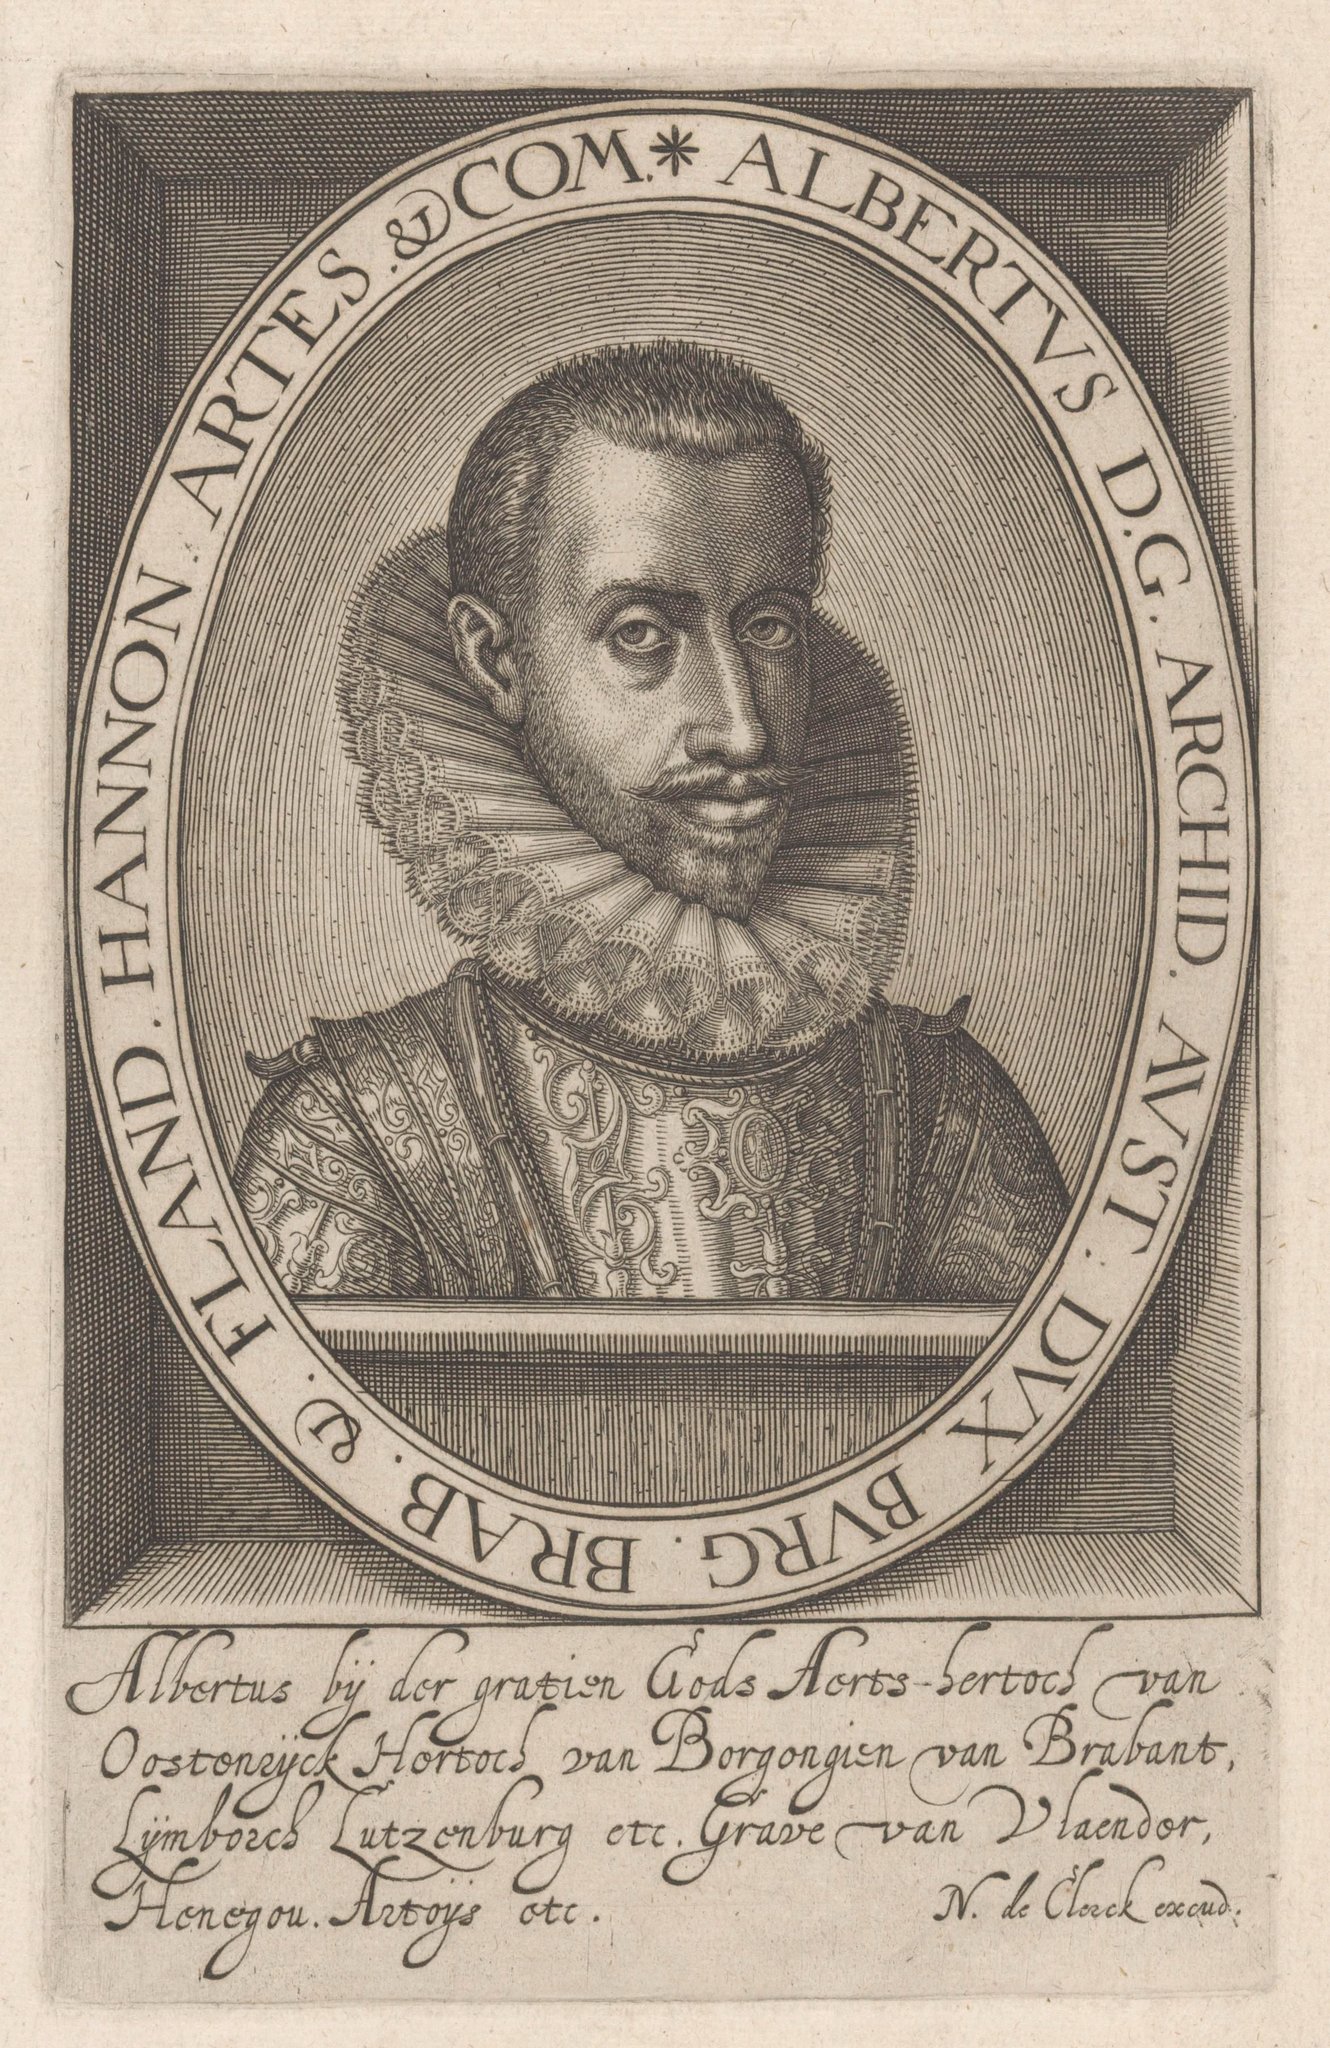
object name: print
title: Portret van Albrecht, aartshertog van Oostenrijk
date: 1599-1623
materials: paper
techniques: engraving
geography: northern netherlands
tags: brussels, albrecht aartshertog van oostenrijk